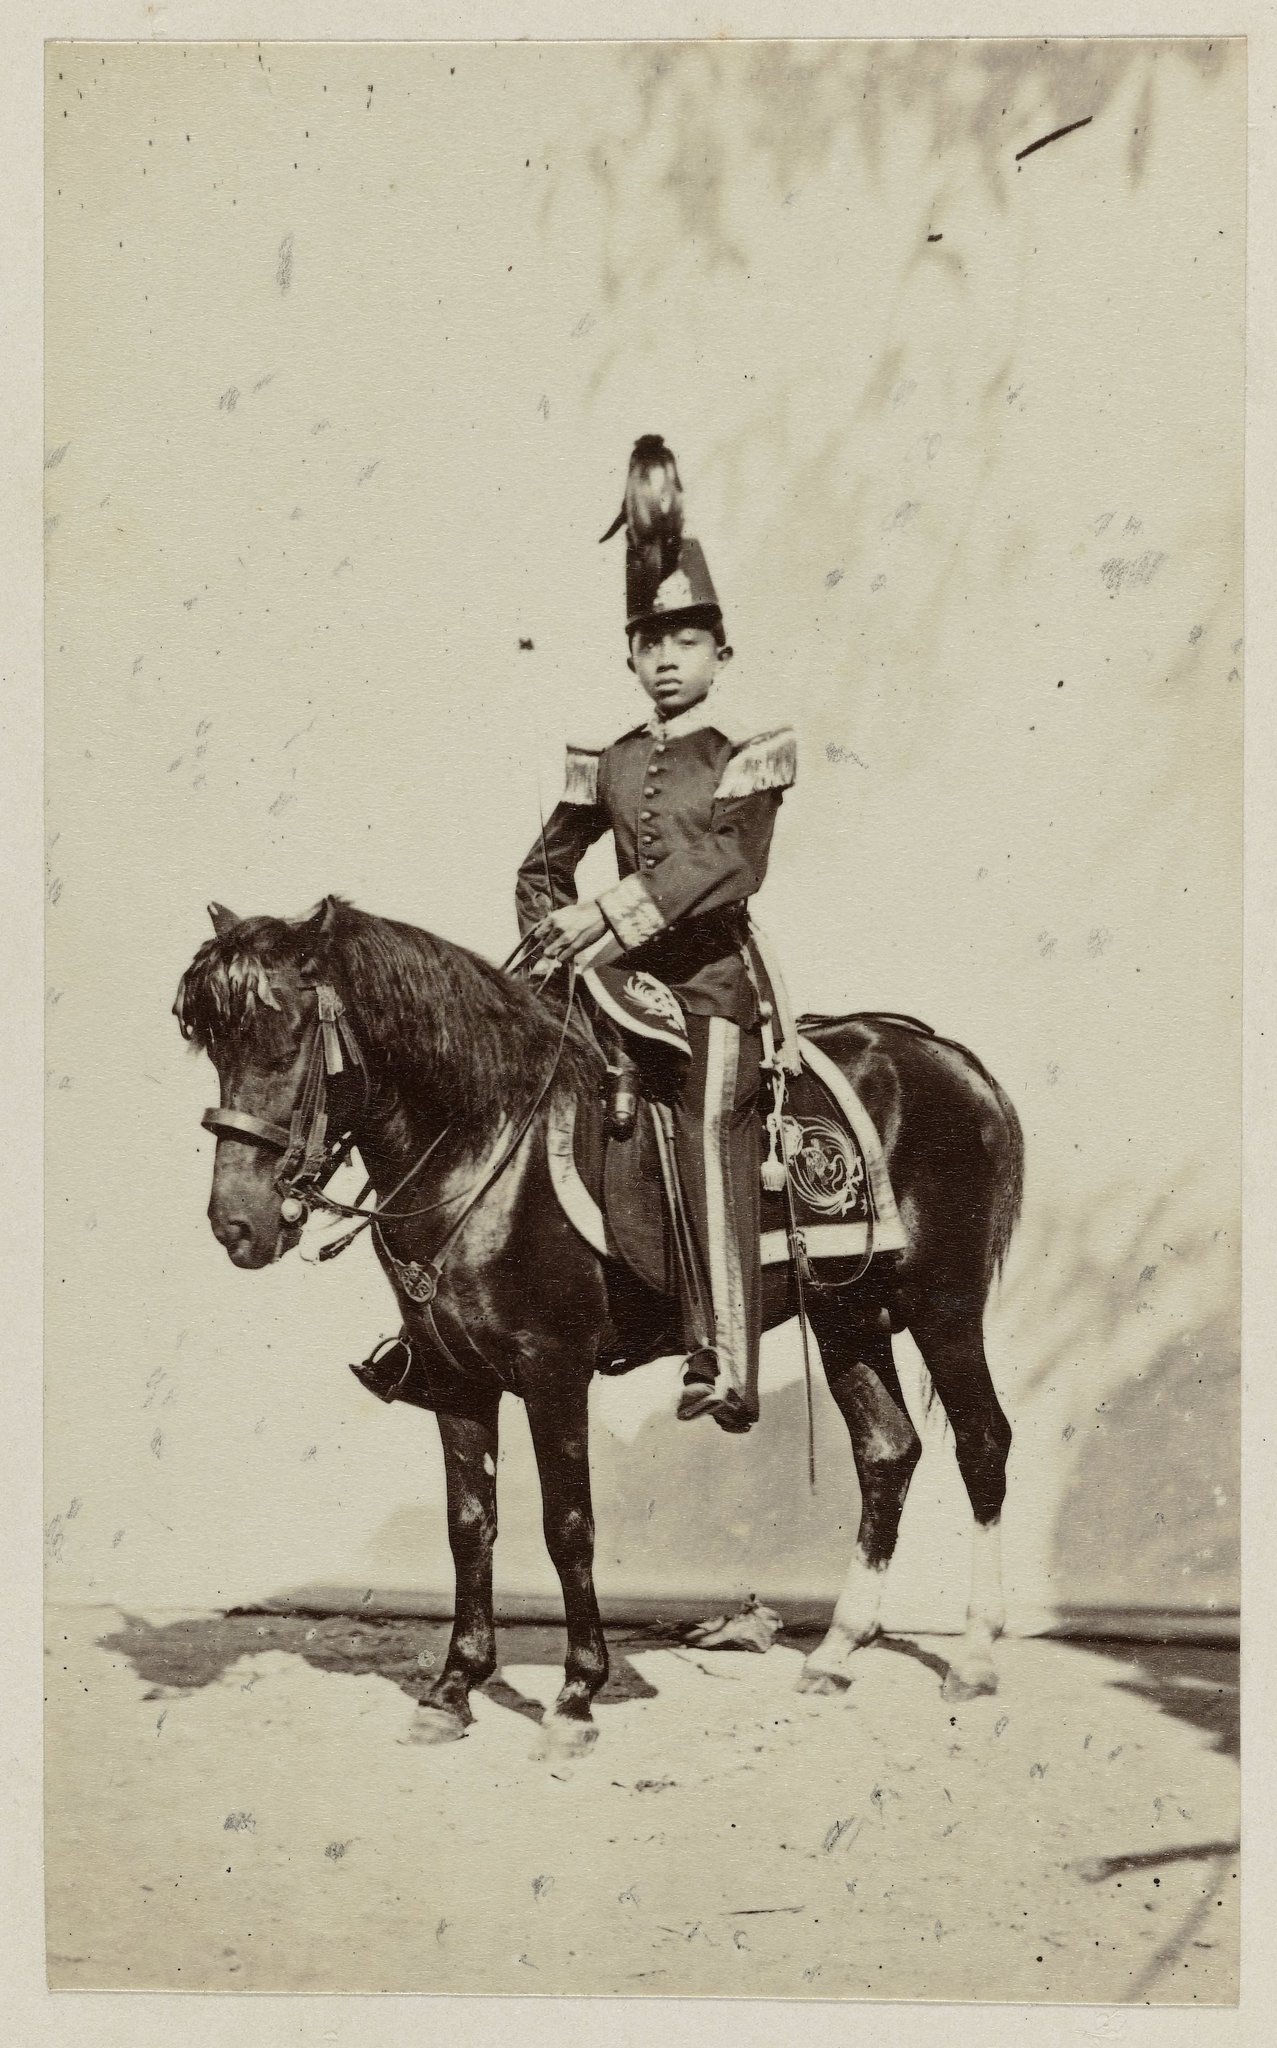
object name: photograph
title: Jonge Javaanse vorst te paard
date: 1865-1890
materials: photographic support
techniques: albumen print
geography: batavia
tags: equestrian state-portrait, ruler, sovereign, historical persons not known by name, java, batavia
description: Studioportret van een jonge Javaanse vorst gezeten op een paard. Ingeplakte foto in het fotoalbum getiteld: Gezichten van Java.